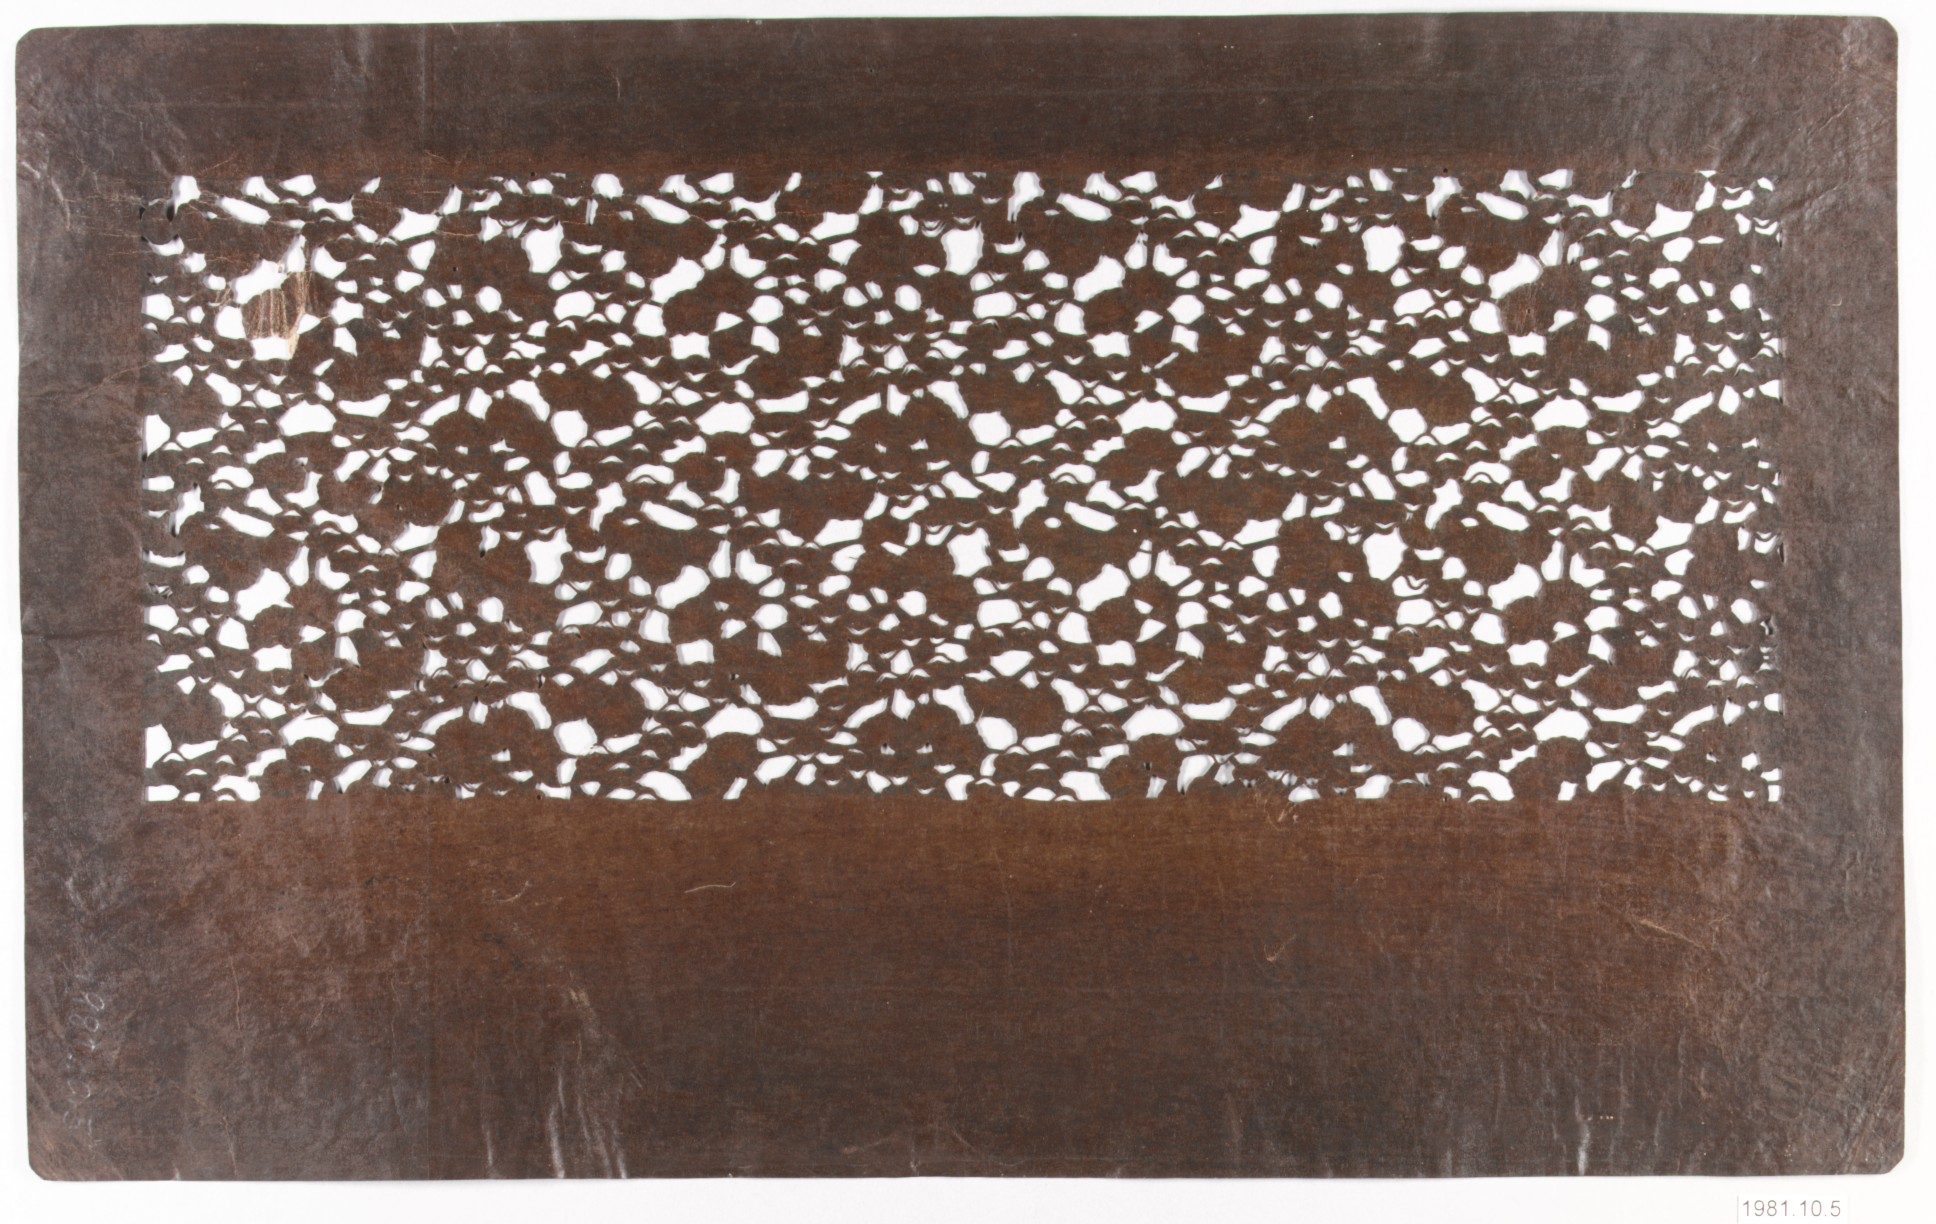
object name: stencil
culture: japanese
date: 1801-1900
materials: paper